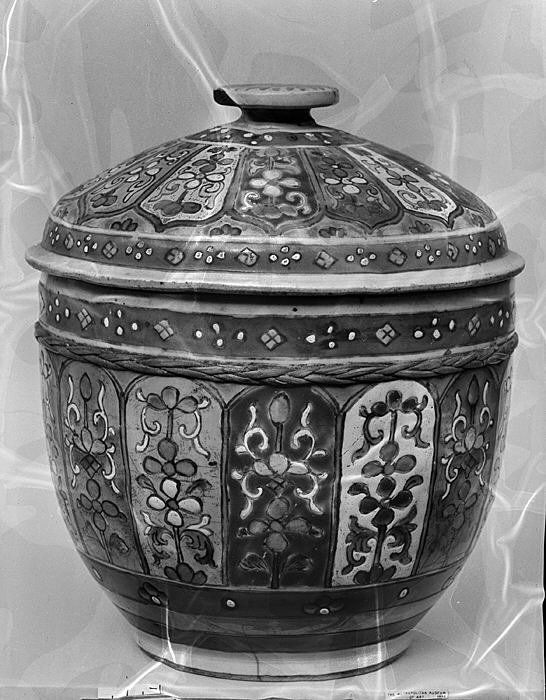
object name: covered bowl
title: Covered bowl with floral pattern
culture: chinese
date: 1801-1900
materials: enamel, porcelain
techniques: overglaze, painting, polychrome